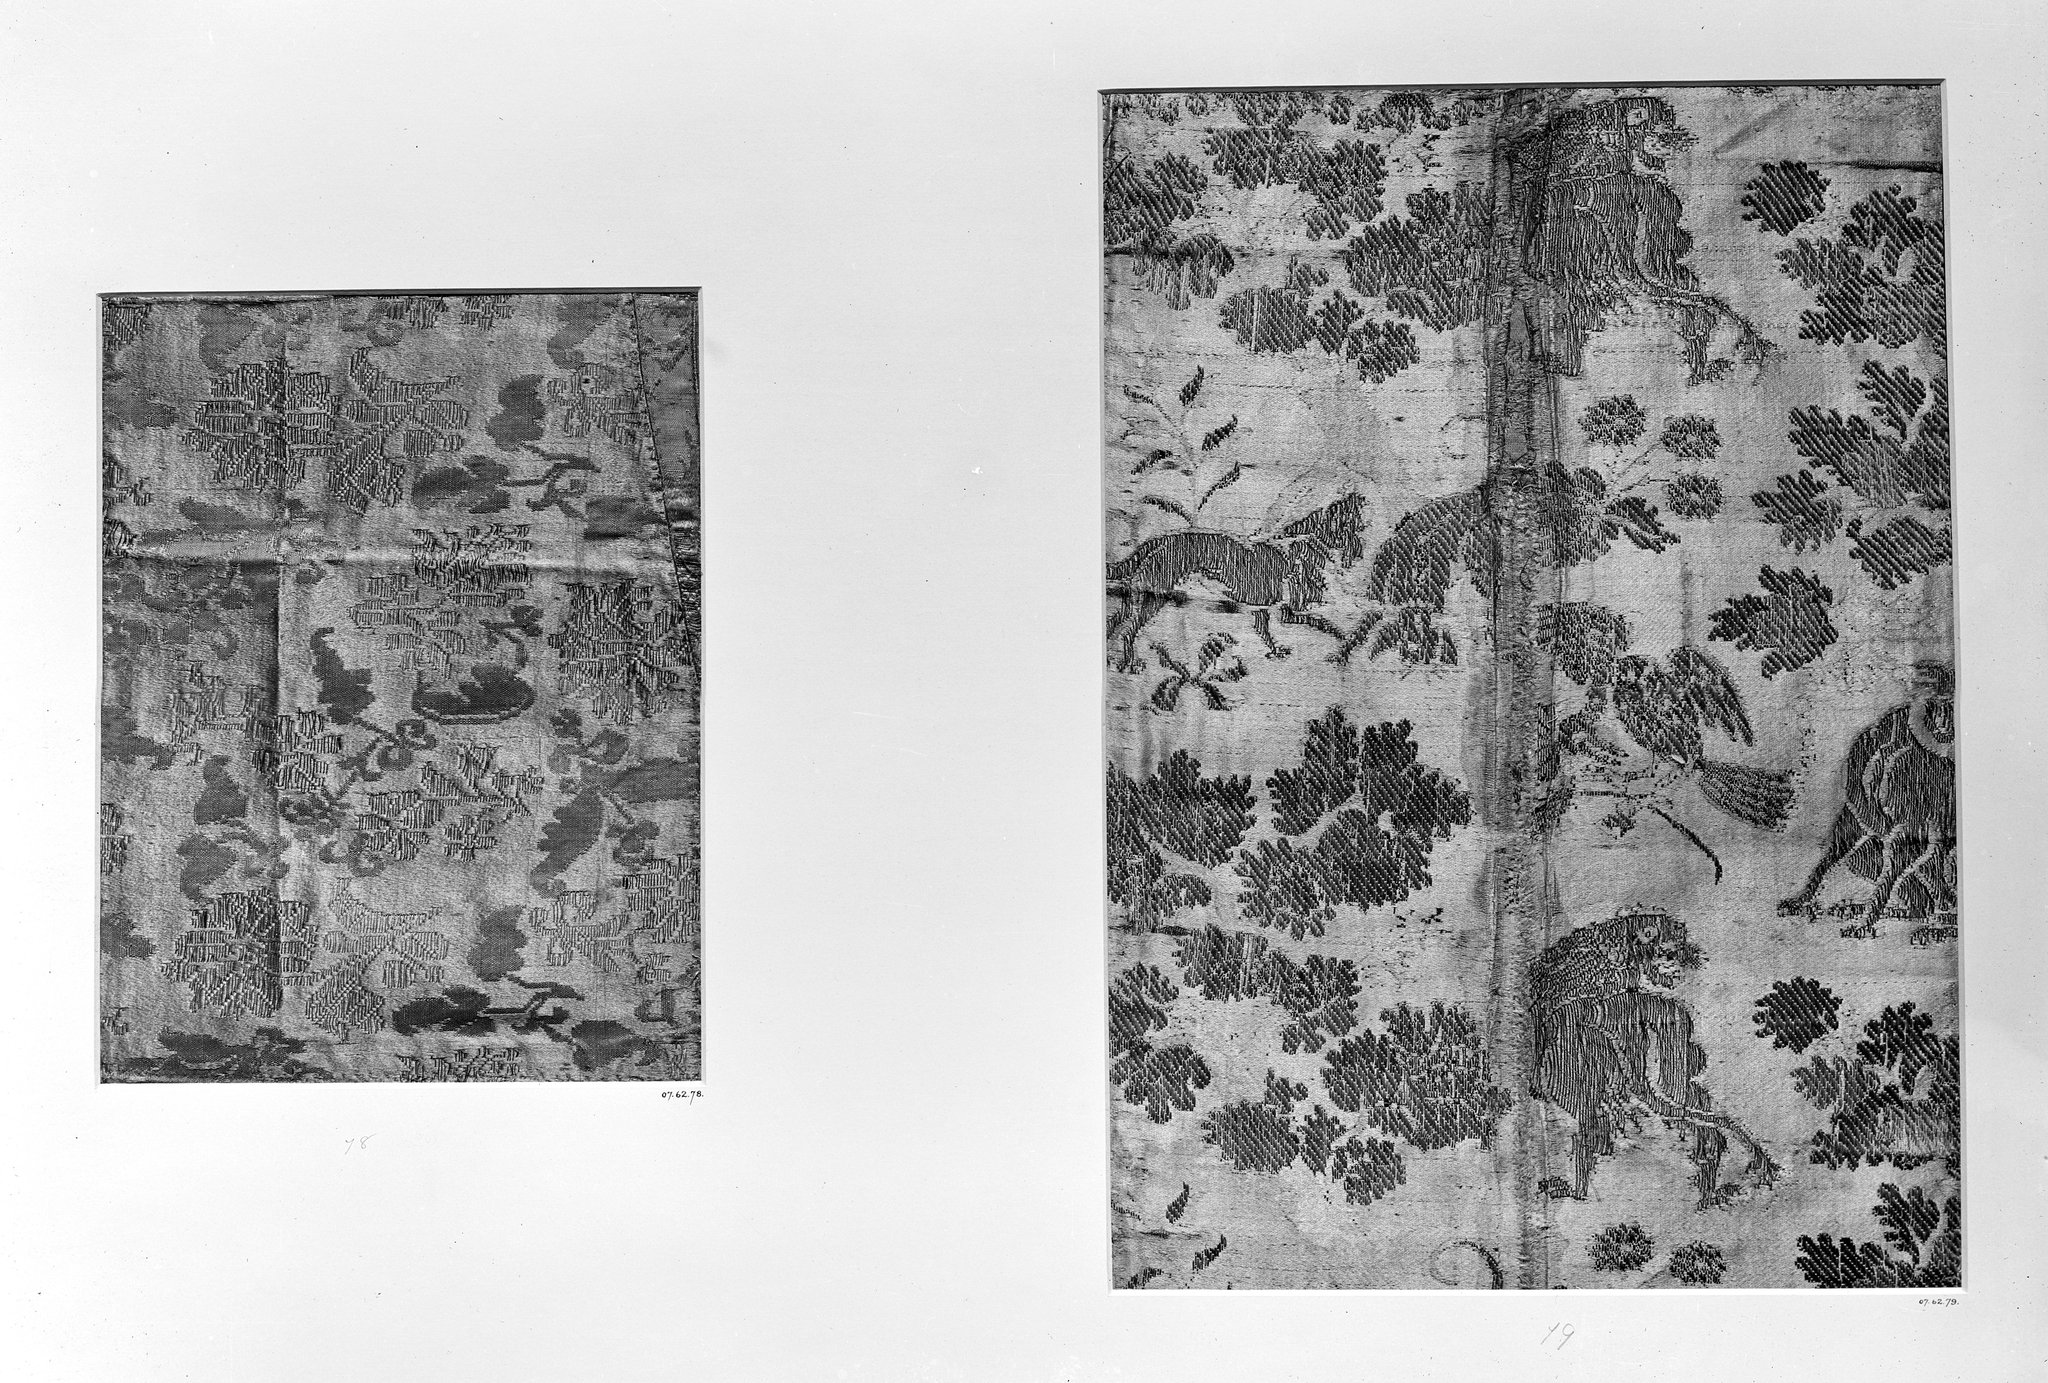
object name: piece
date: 1701-1800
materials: metal thread, silk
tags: animals,birds,trees